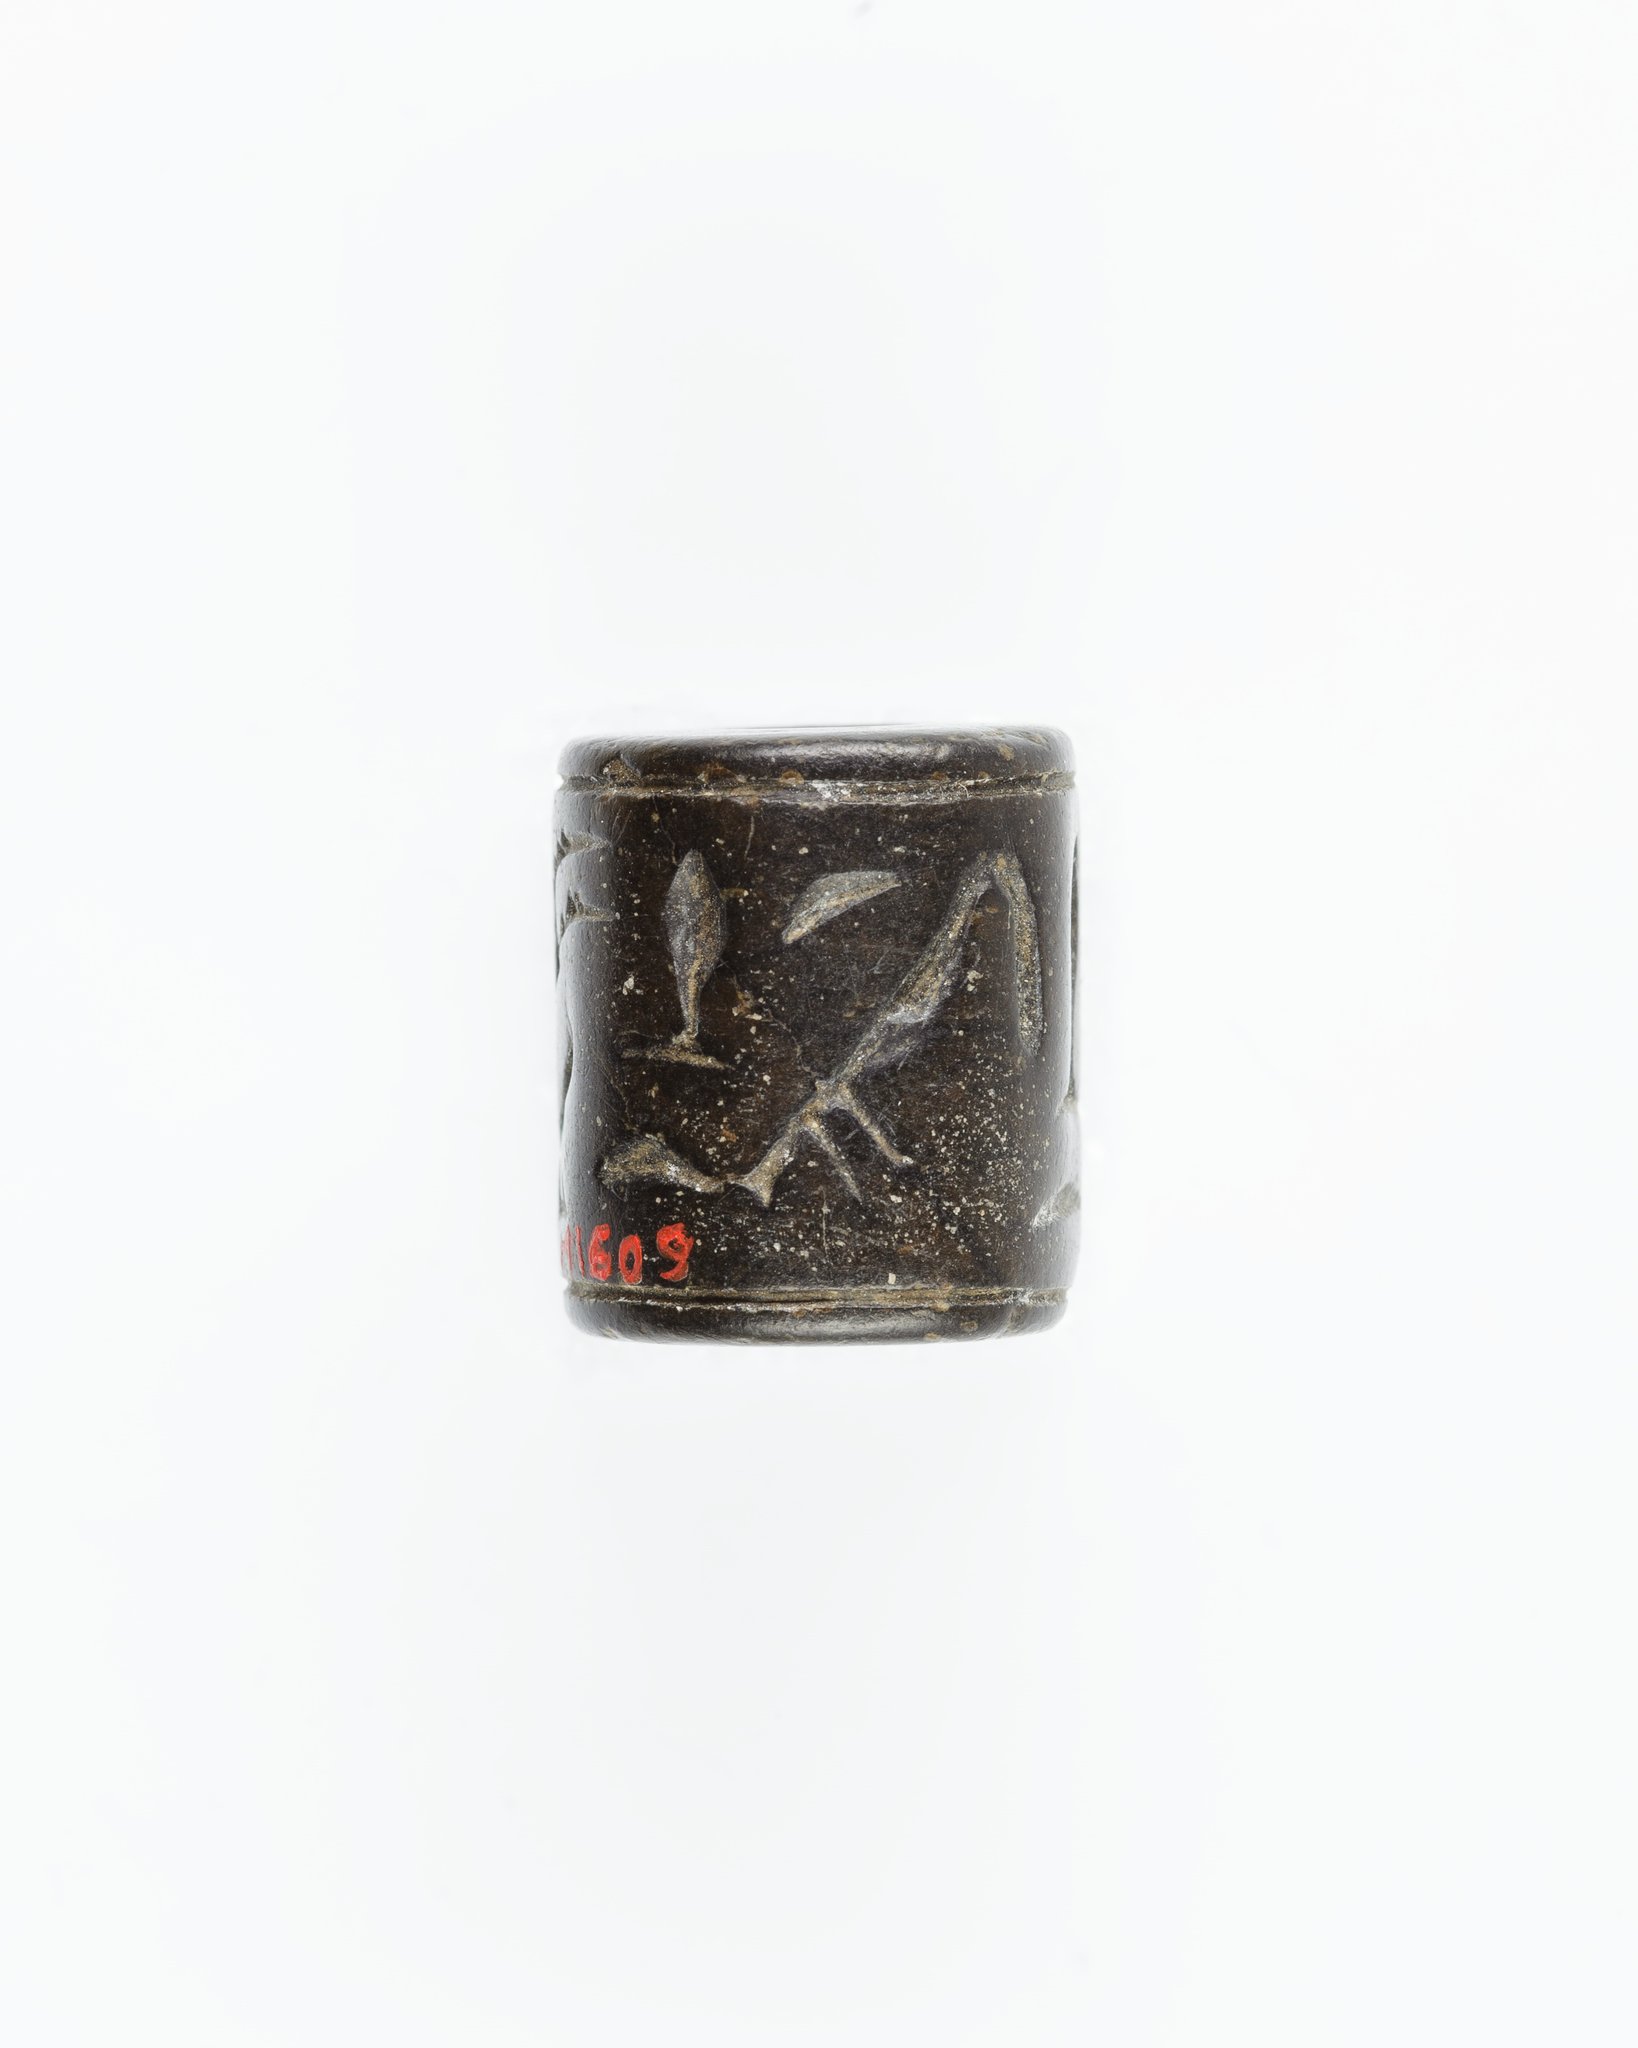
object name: cylinder seal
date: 2960-2649 BCE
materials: stone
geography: egypt